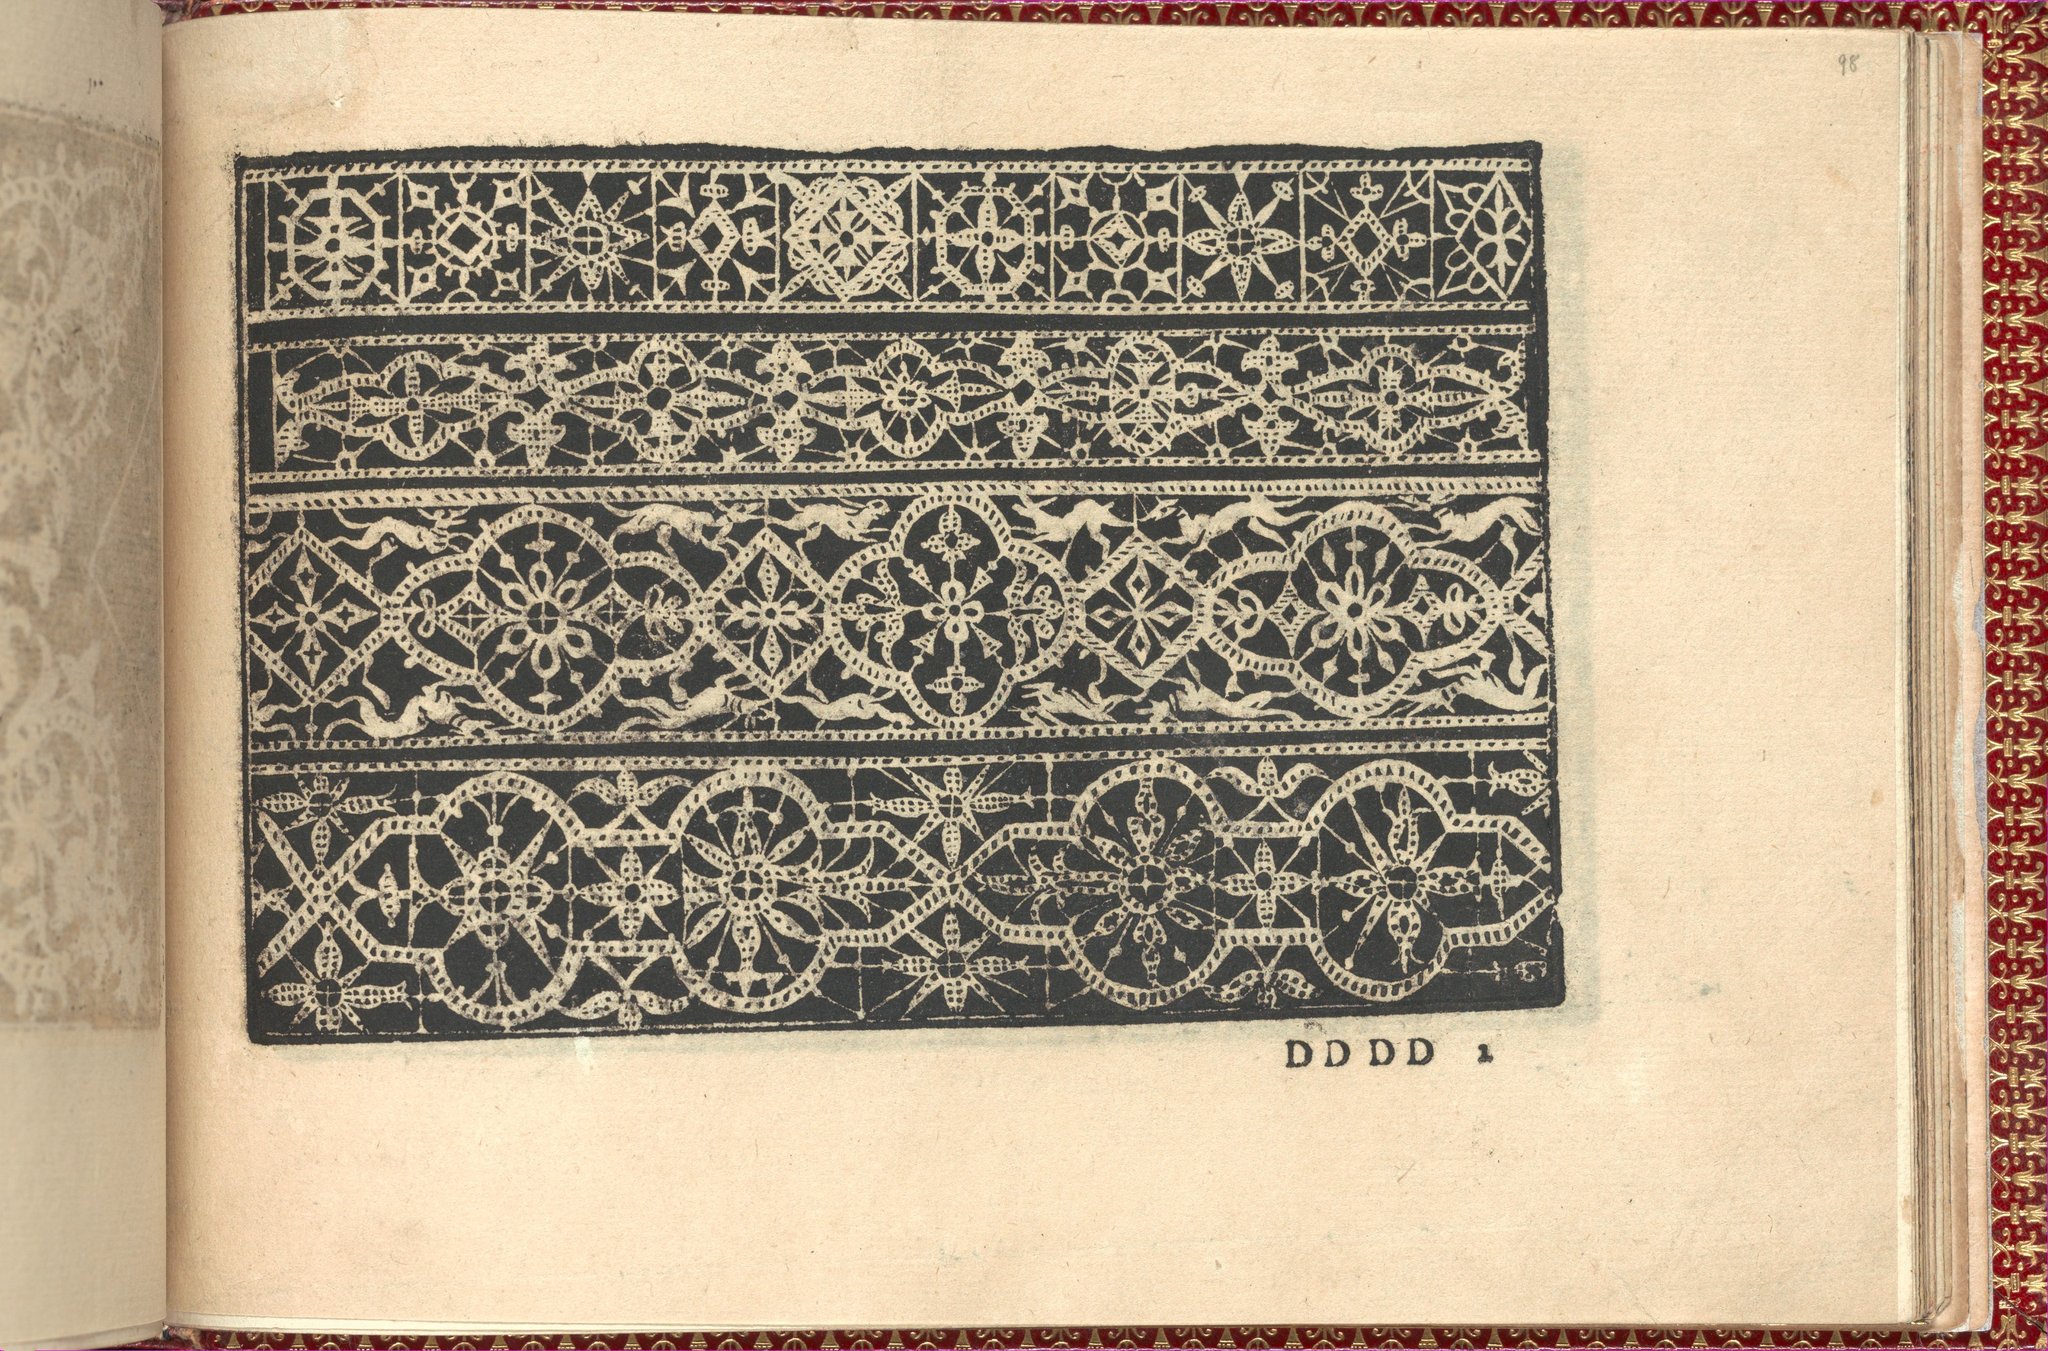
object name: book print ornament architecture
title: Corona delle Nobili et Virtuose Donne: Libro I-IV, page 98 (recto)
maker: cesare vecellio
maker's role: publisher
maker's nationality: italian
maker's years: 1521-1601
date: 1601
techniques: woodcut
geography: italy